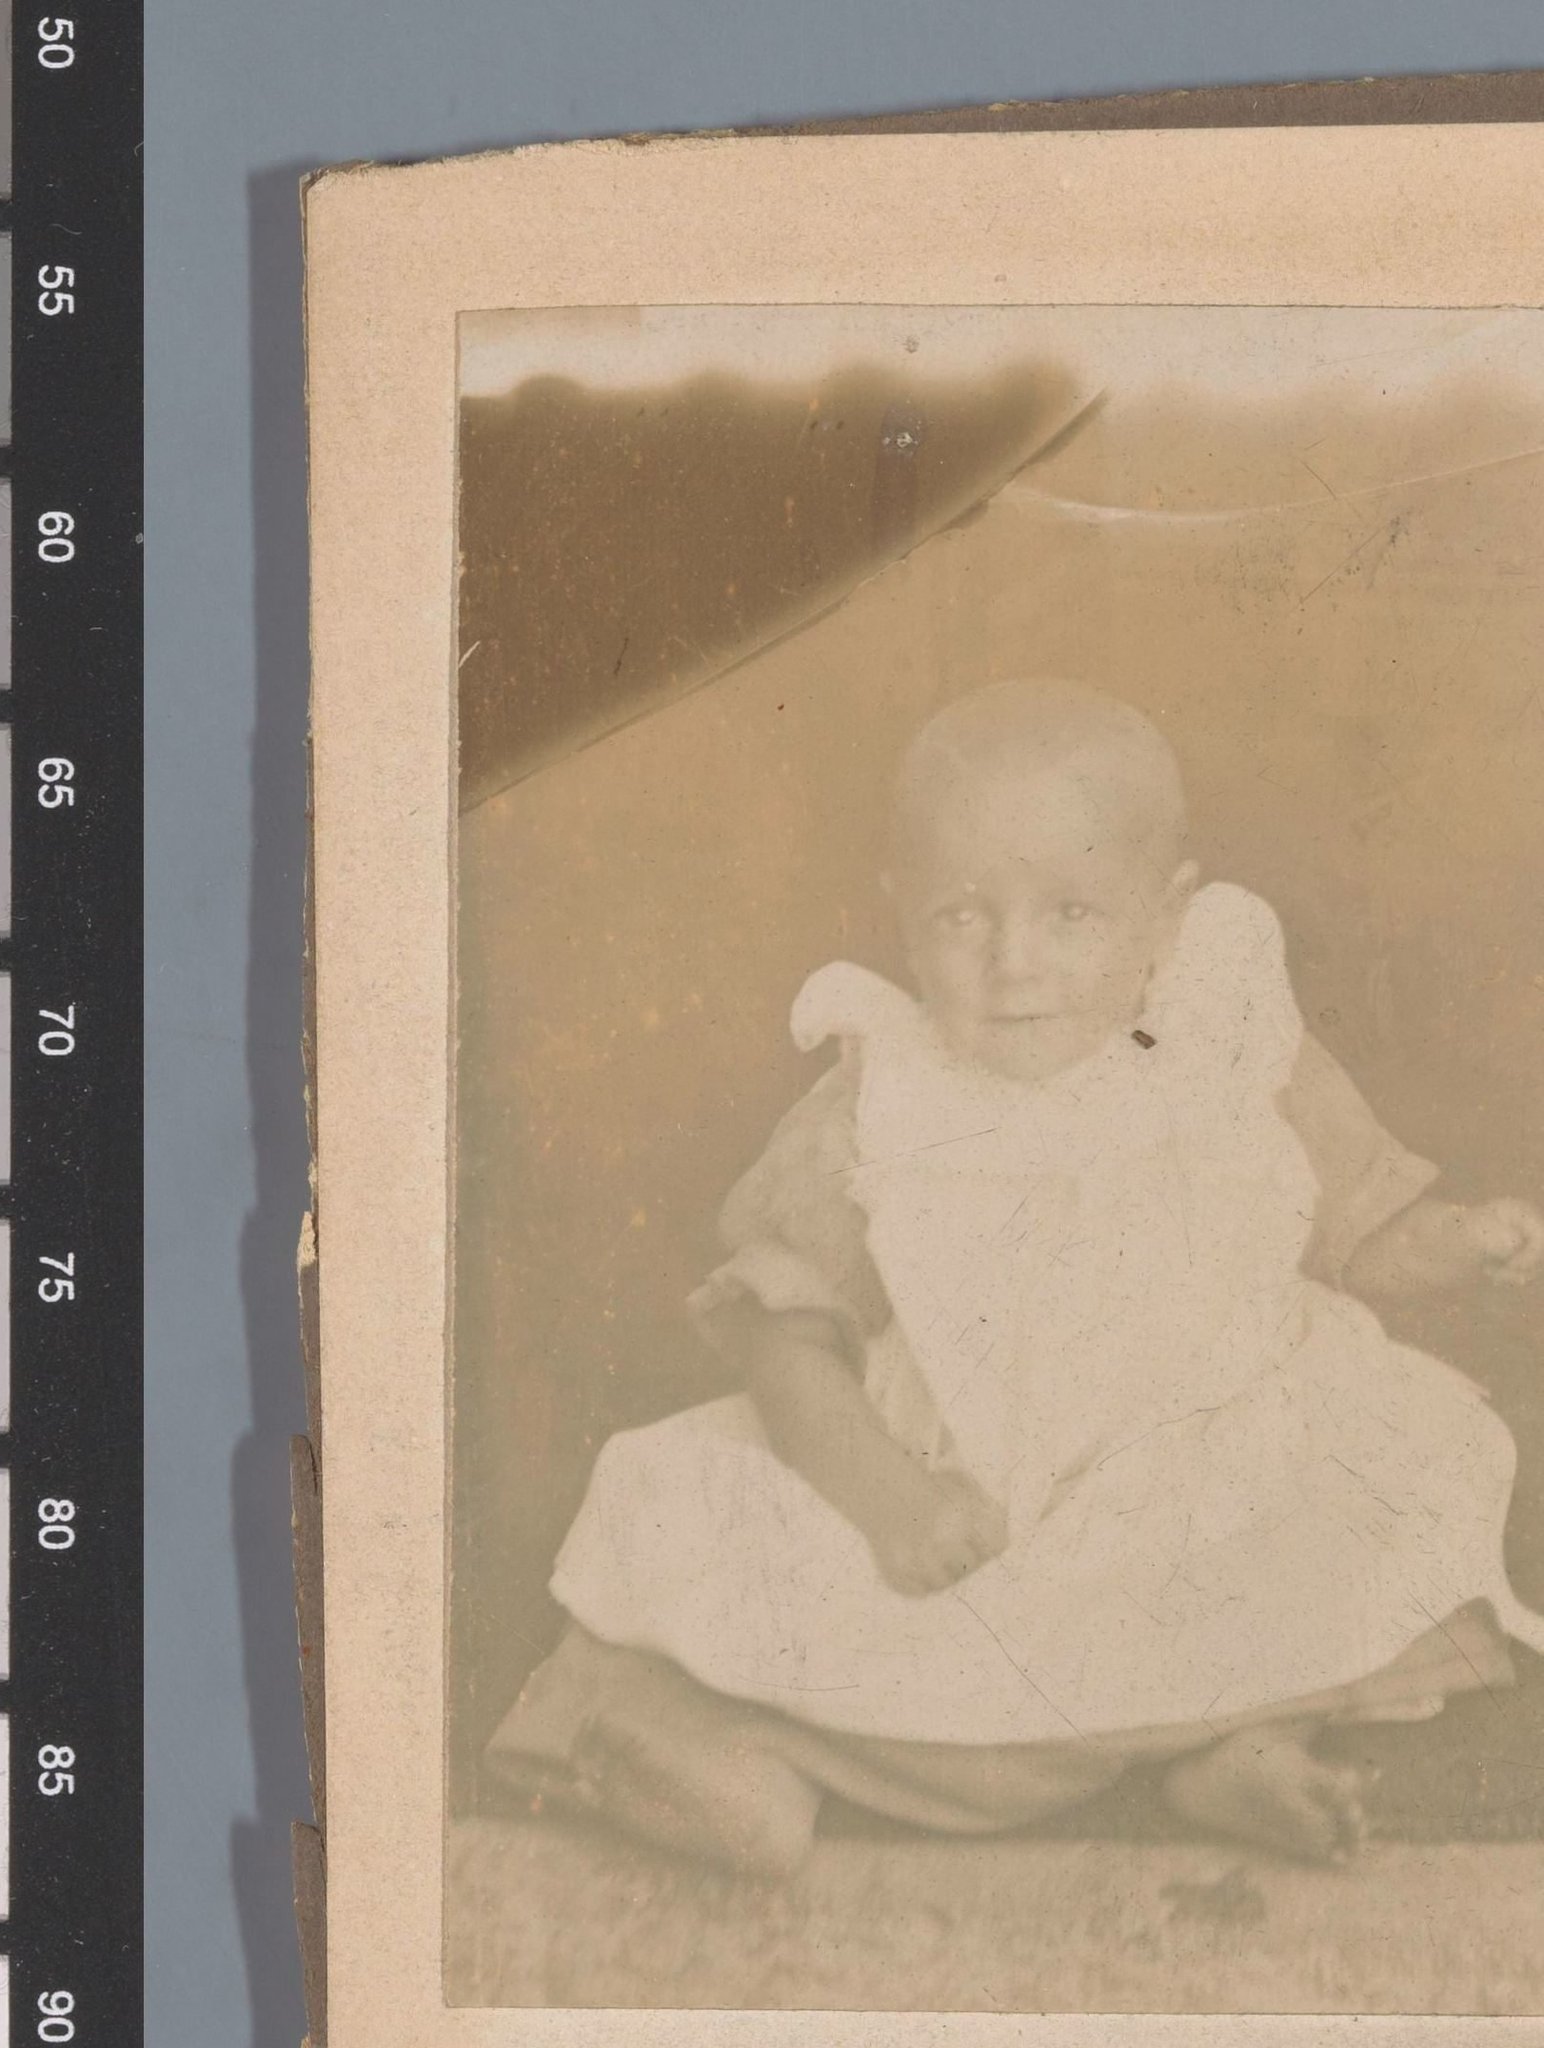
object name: photograph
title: Portret van een onbekende baby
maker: Anonymous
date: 1900-1920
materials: photographic support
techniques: gelatin silver print, snipping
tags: infant, baby